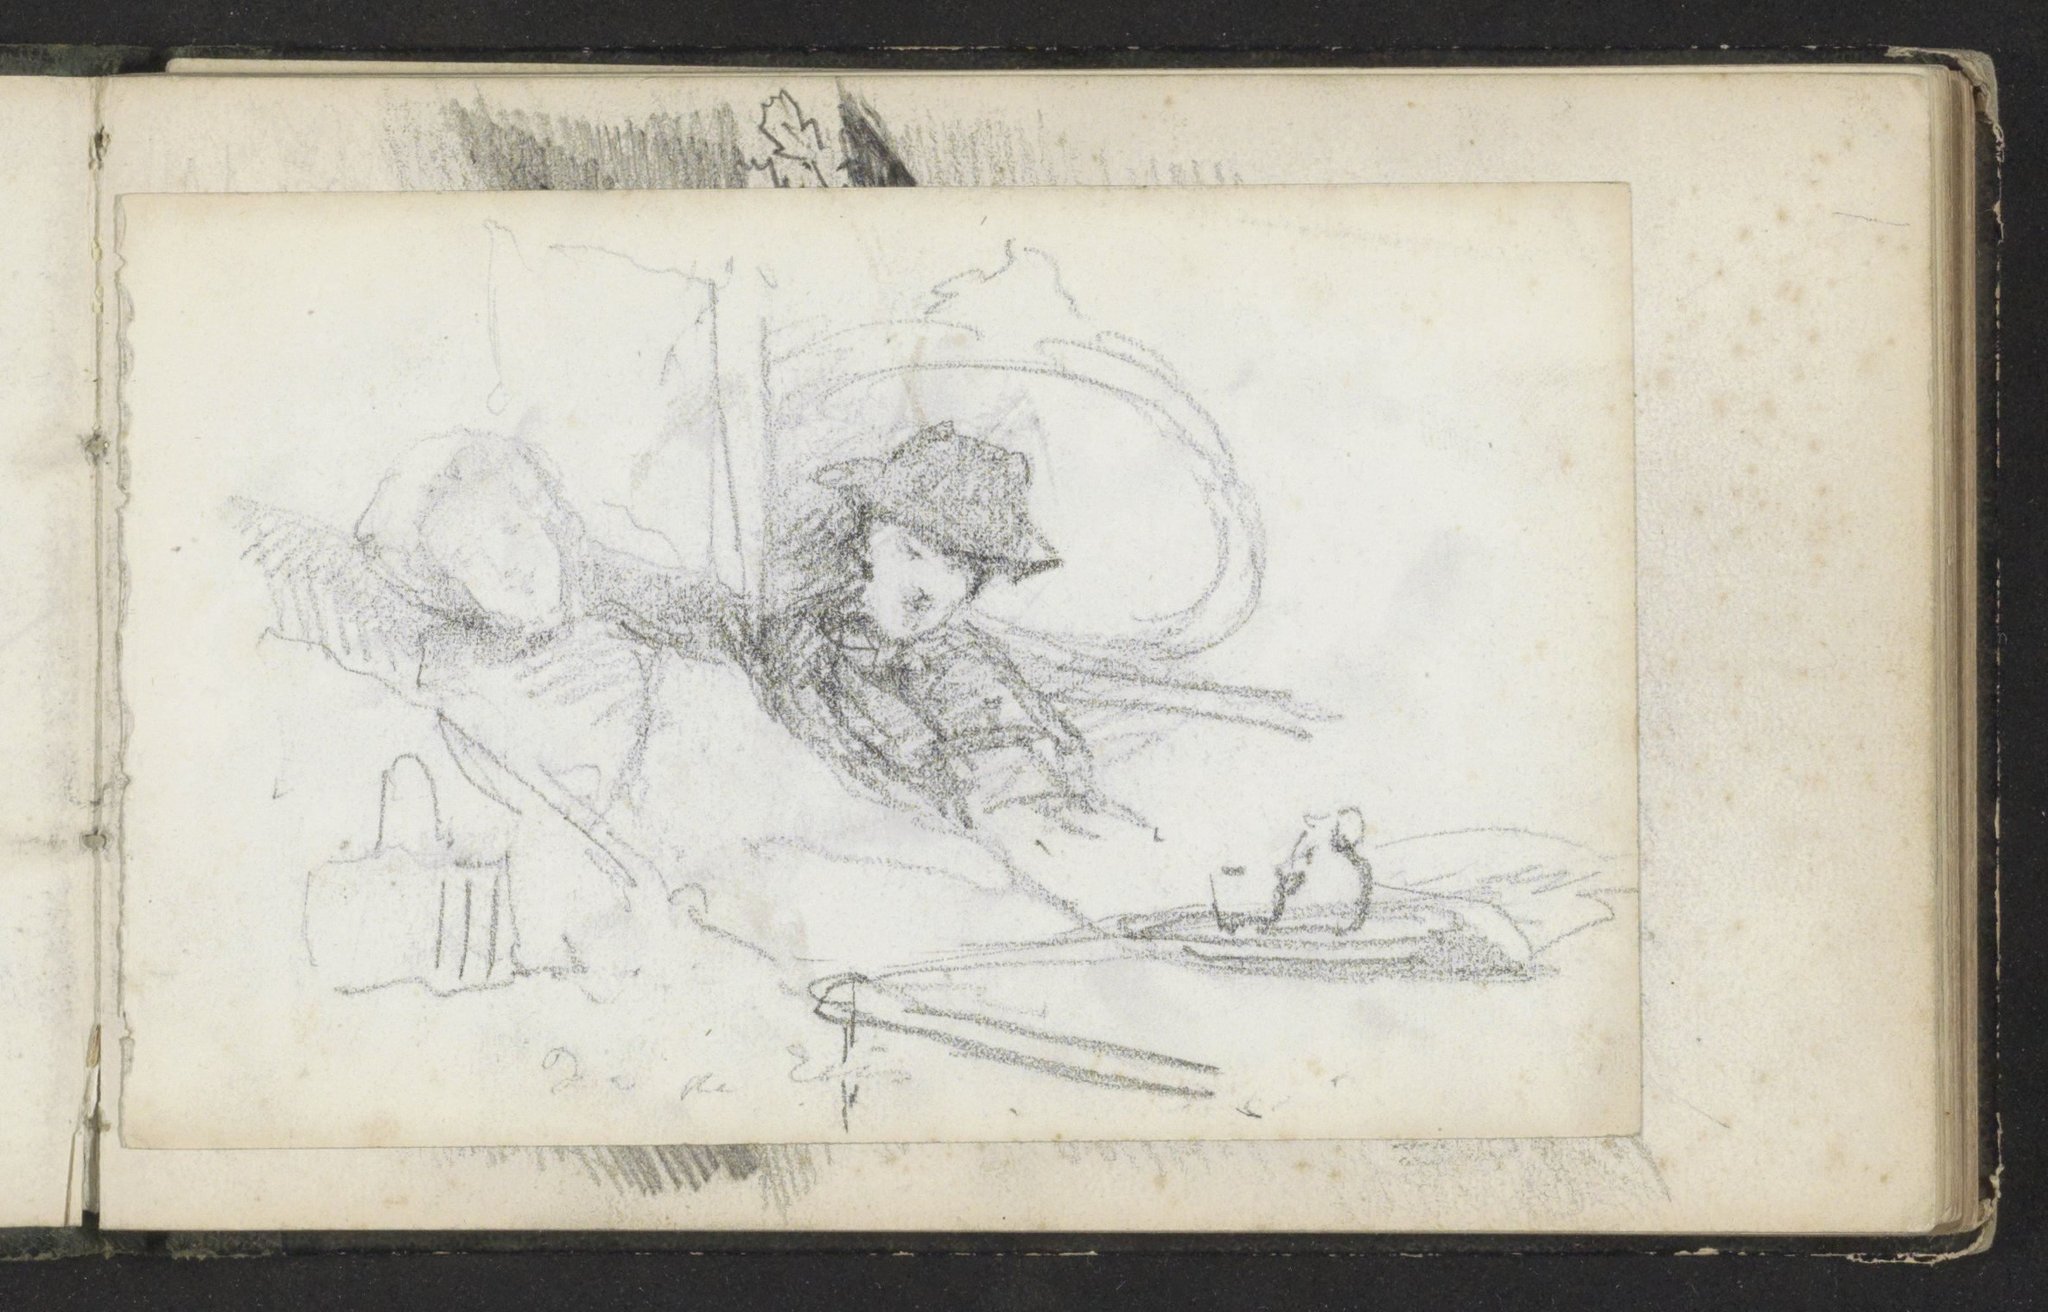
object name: sketchbook leaf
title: Man en vrouw in een interieur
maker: maria vos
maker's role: draughtsman, painter, print maker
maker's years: 1824-1906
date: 1856-1870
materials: paper, pencil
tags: adult woman, adult man, interior of the house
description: Losse tekening tussen het voorste schutblad en pagina 1 recto van een schetsboek met 39 bladen.